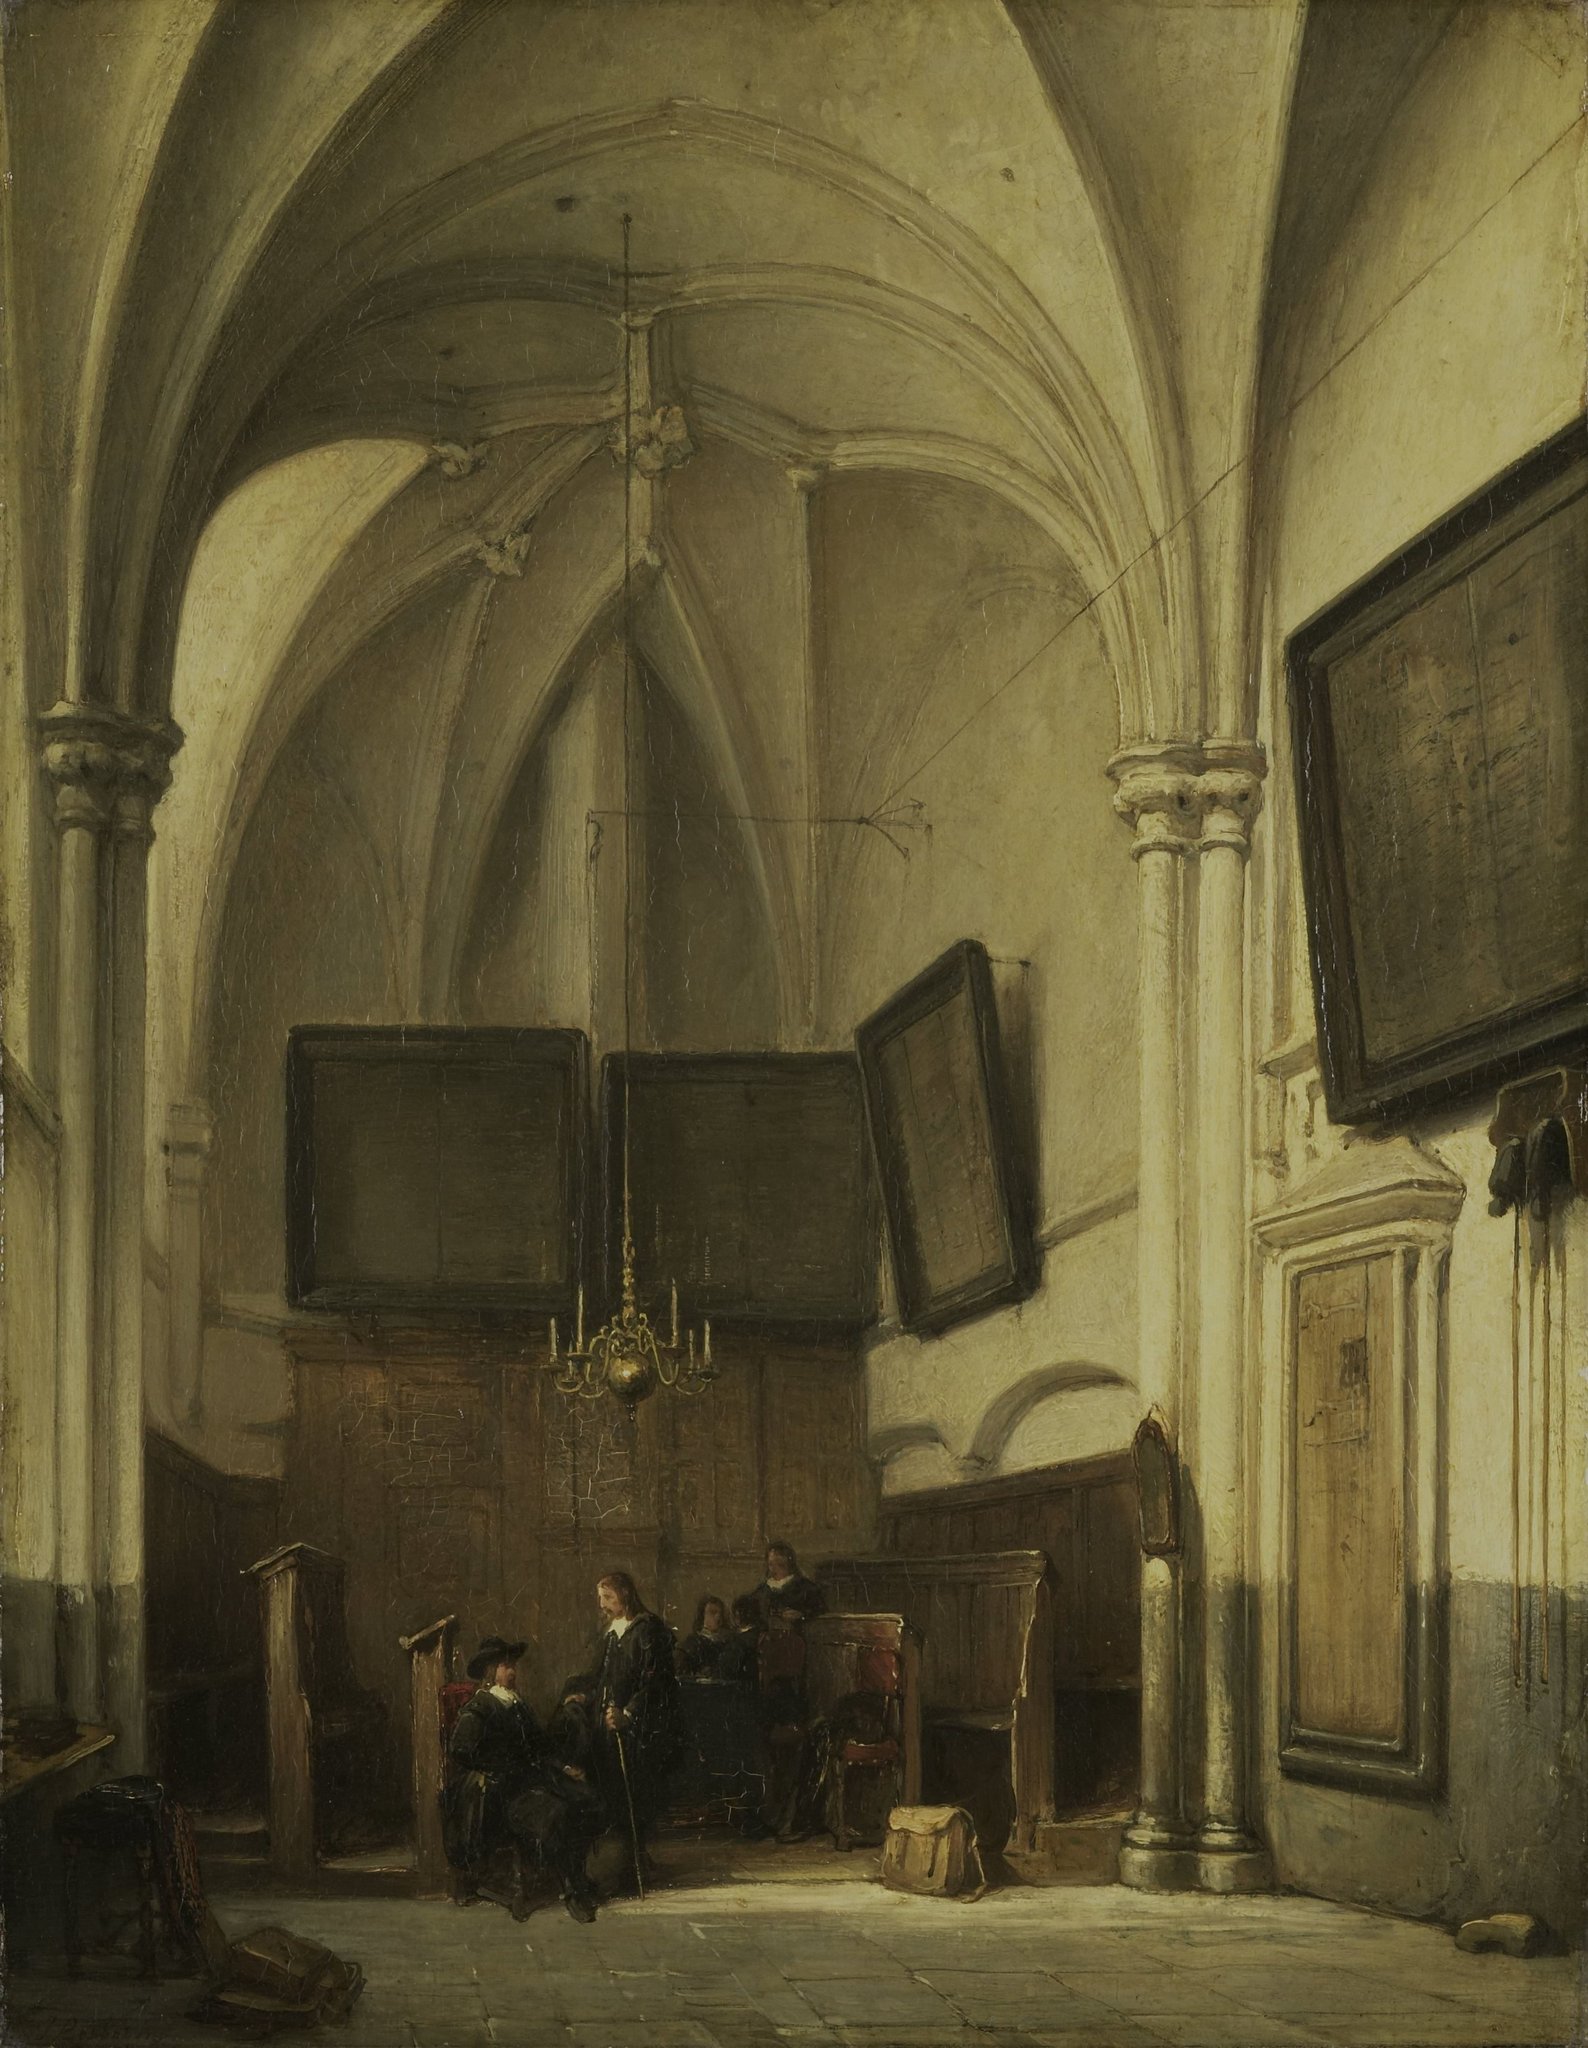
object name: painting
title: Vestry of the Church of St Stephen in Nijmegen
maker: johannes bosboom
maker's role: draughtsman, painter, print maker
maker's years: 1817-1891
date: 1850-1891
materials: oil, panel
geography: netherlands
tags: interior of church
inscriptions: signature: ‘J. Bosboom’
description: De consistoriekamer van de Sint-Stevenskerk te Nijmegen. Kerkinterieur met enkele mannen in en om de houten banken, aan de wanden vier grote schilderijen.